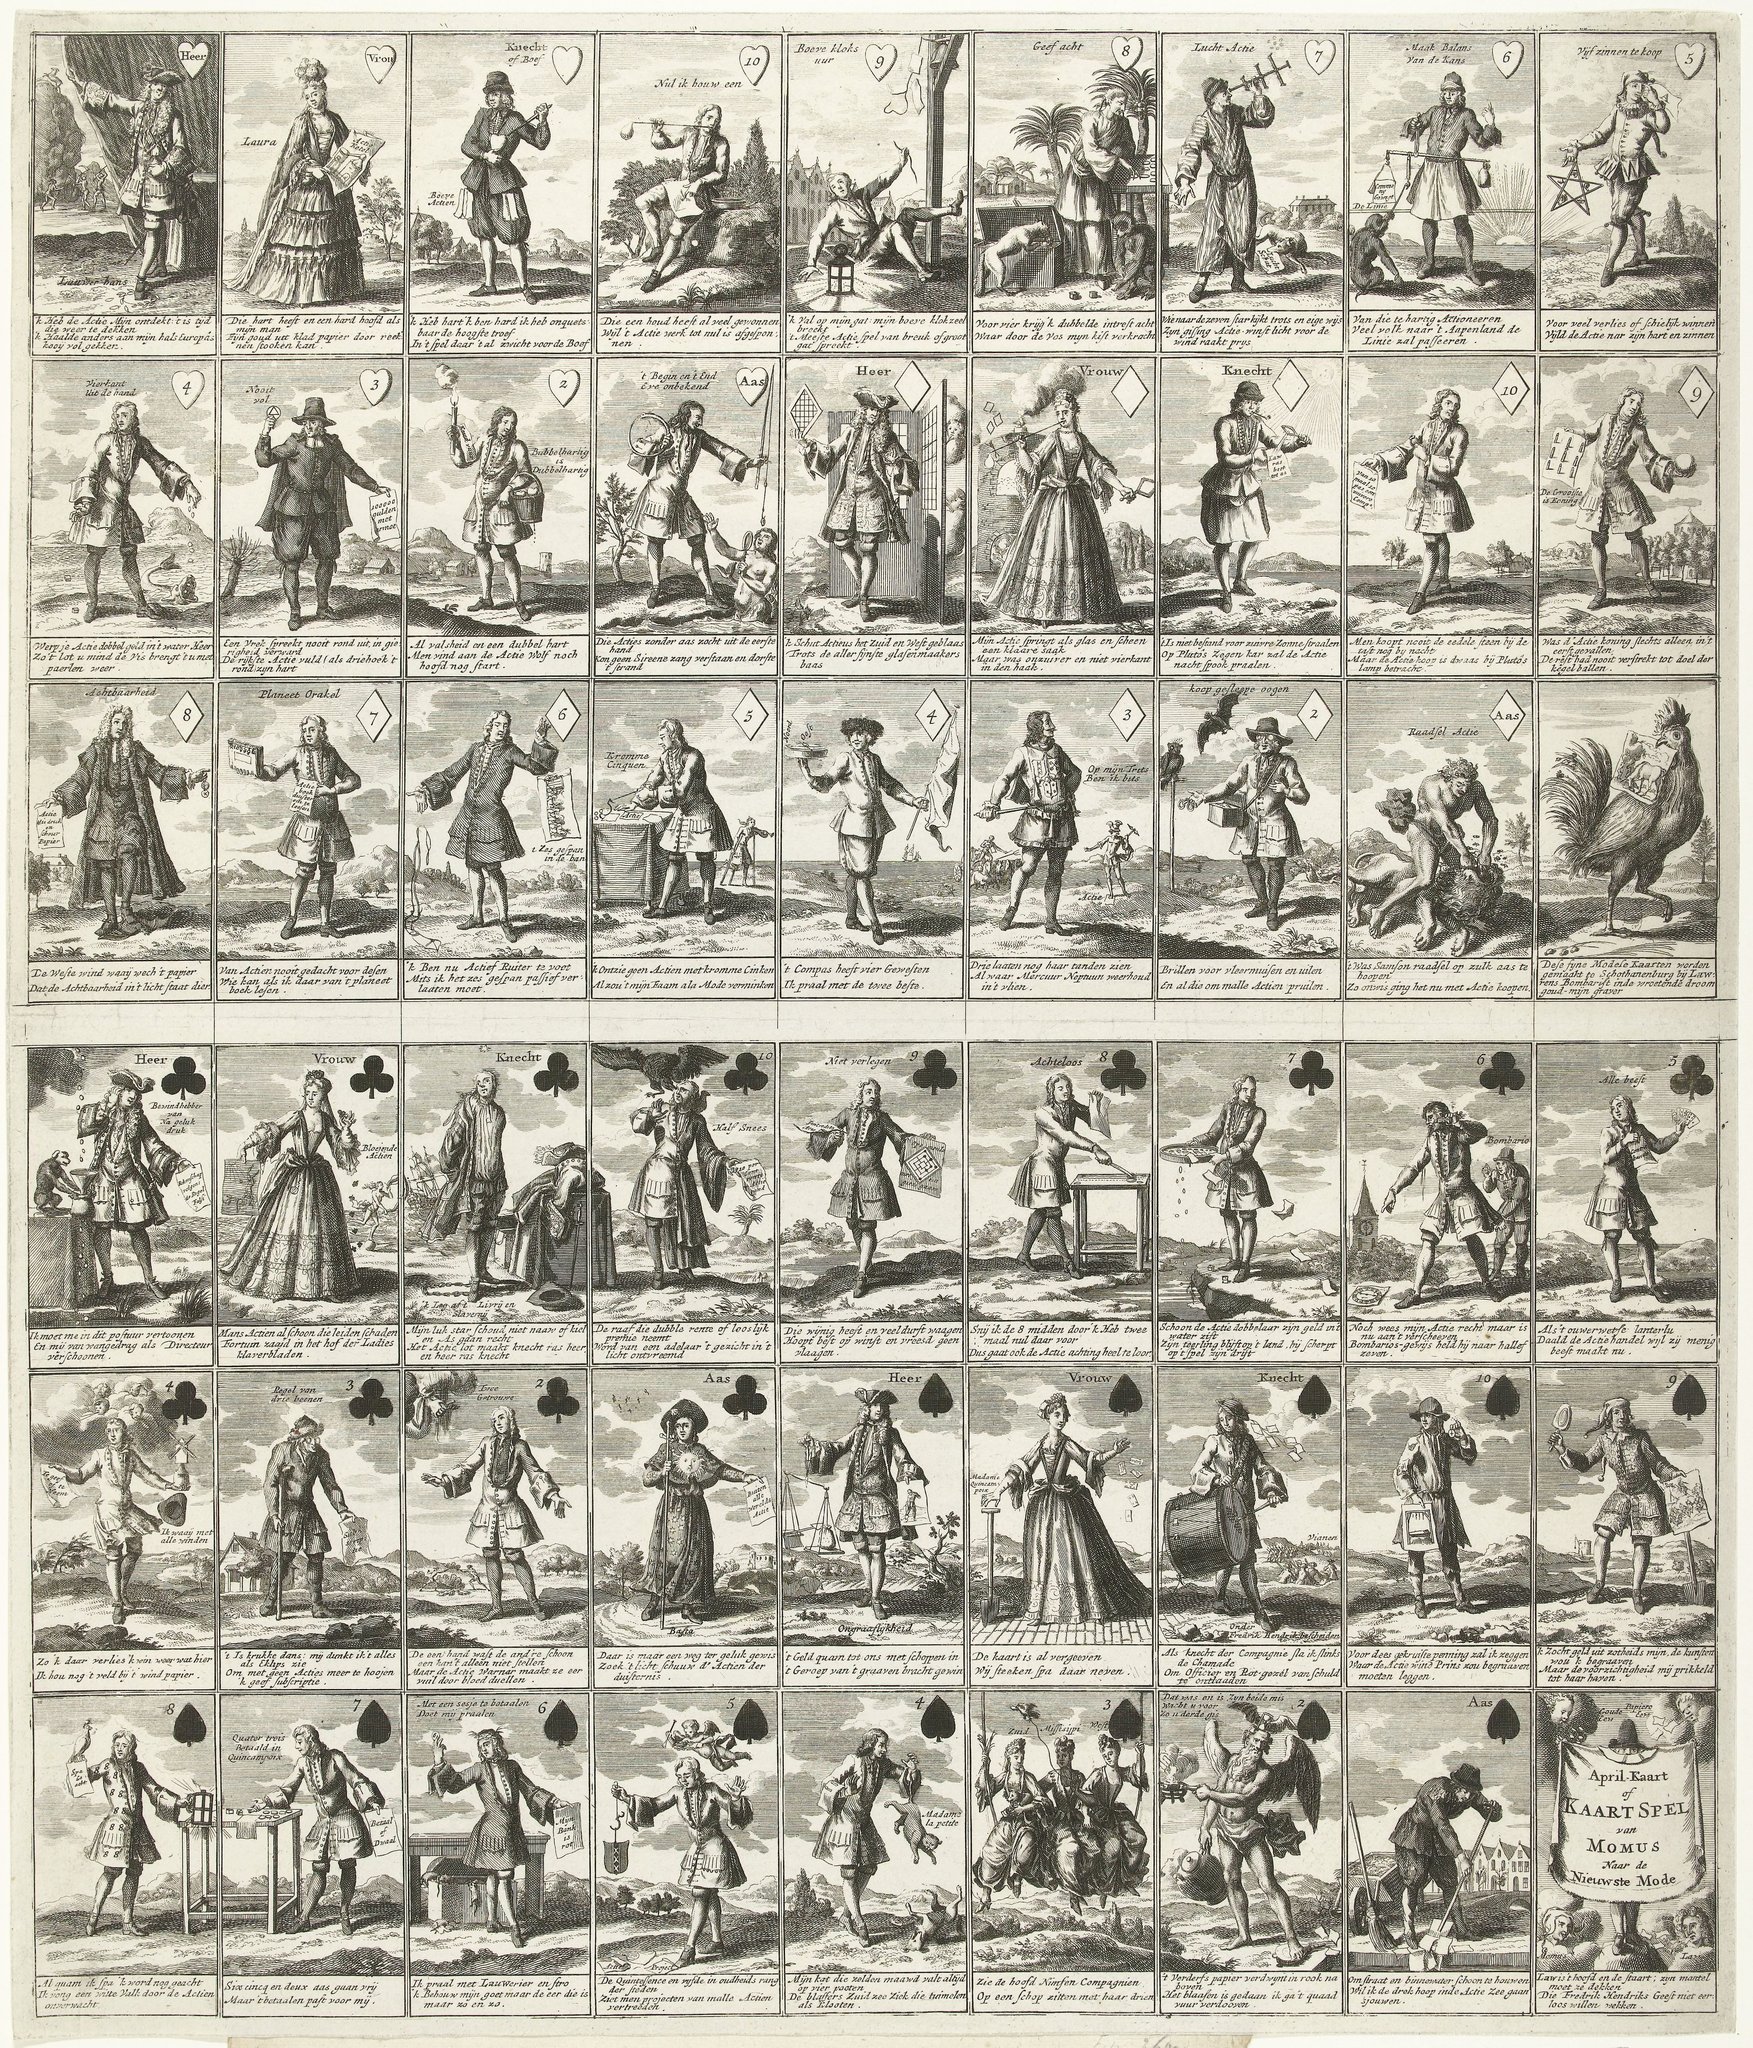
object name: print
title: Het Groote Tafereel der Dwaasheid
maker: Anonymous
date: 1720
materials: paper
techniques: etching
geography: northern netherlands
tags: playing-cards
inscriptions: collector's mark: Lugt 2228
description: April-kaart of kaartspel van Momus. Blad met een compleet spel van 52 speelkaarten, elke kaart met een voorstelling en versje gerelateerd aan de windhandel van 1720. Prent 65 in de serie Het Groote Tafereel der Dwaasheid met spotprenten op de Windhandel of Actiehandel van 1720. Bij het blad behoort een gedrukte verklaring van de voorstellingen.